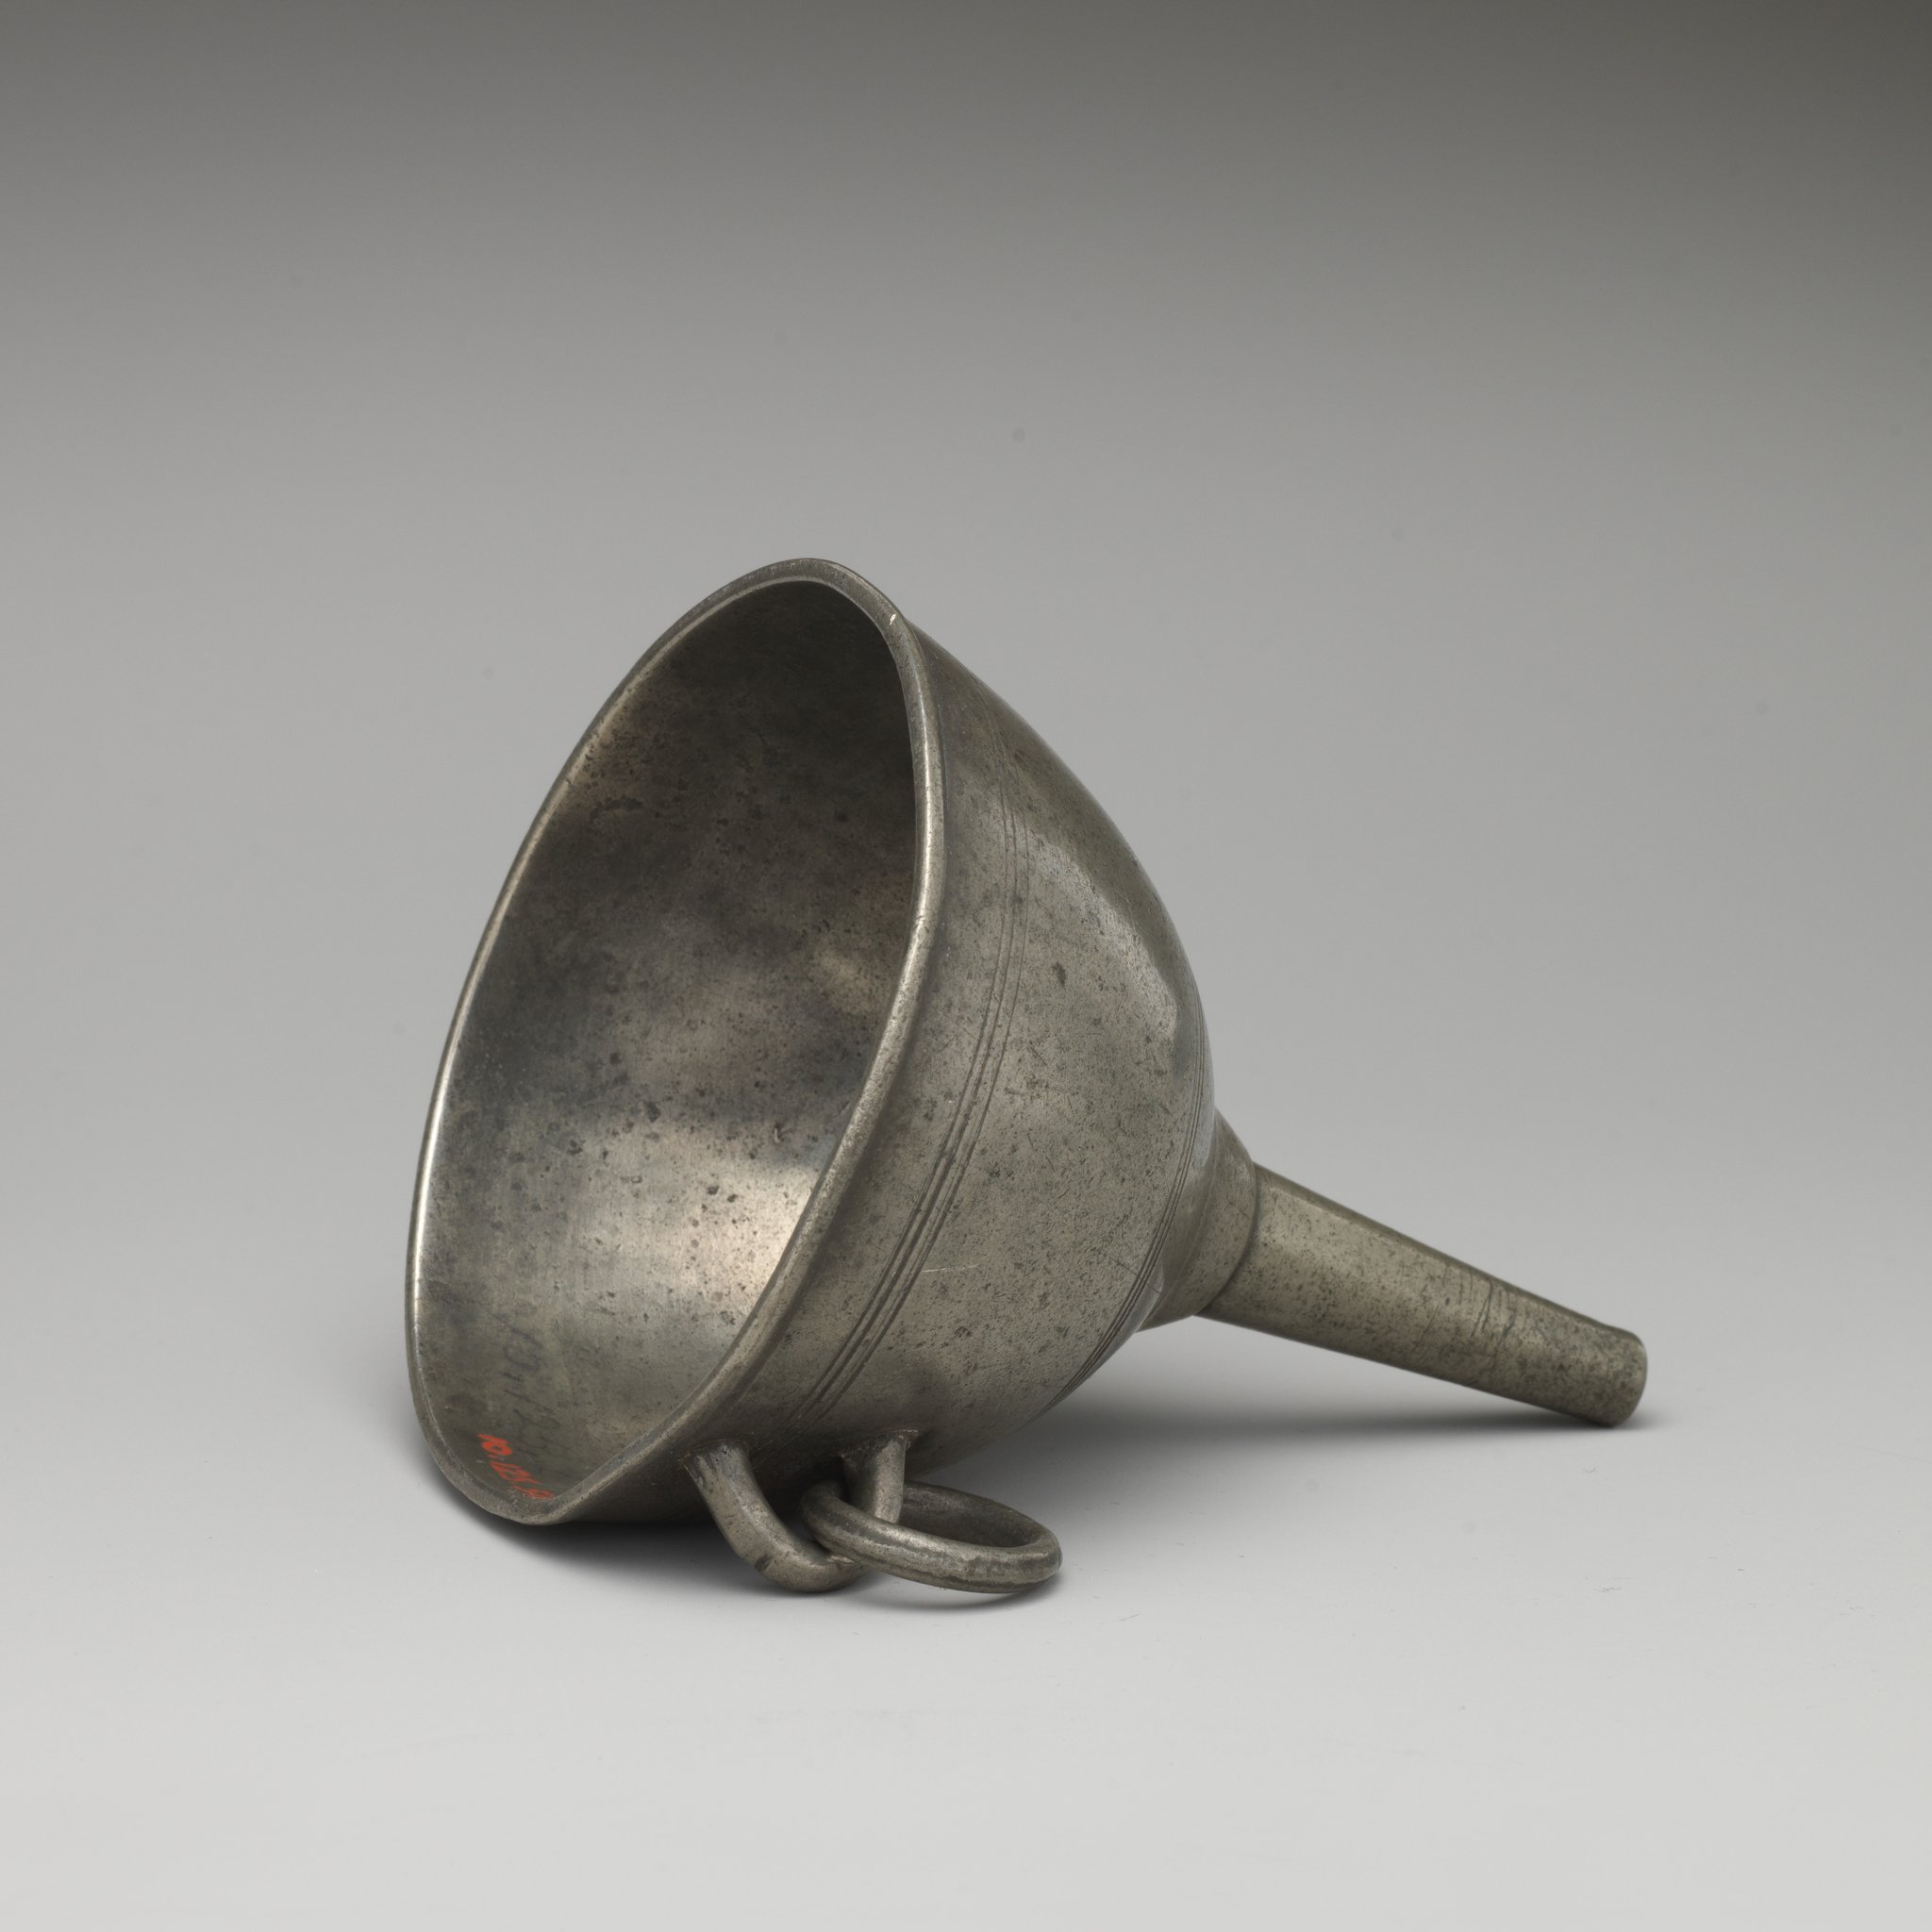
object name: funnel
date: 1701-1800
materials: pewter